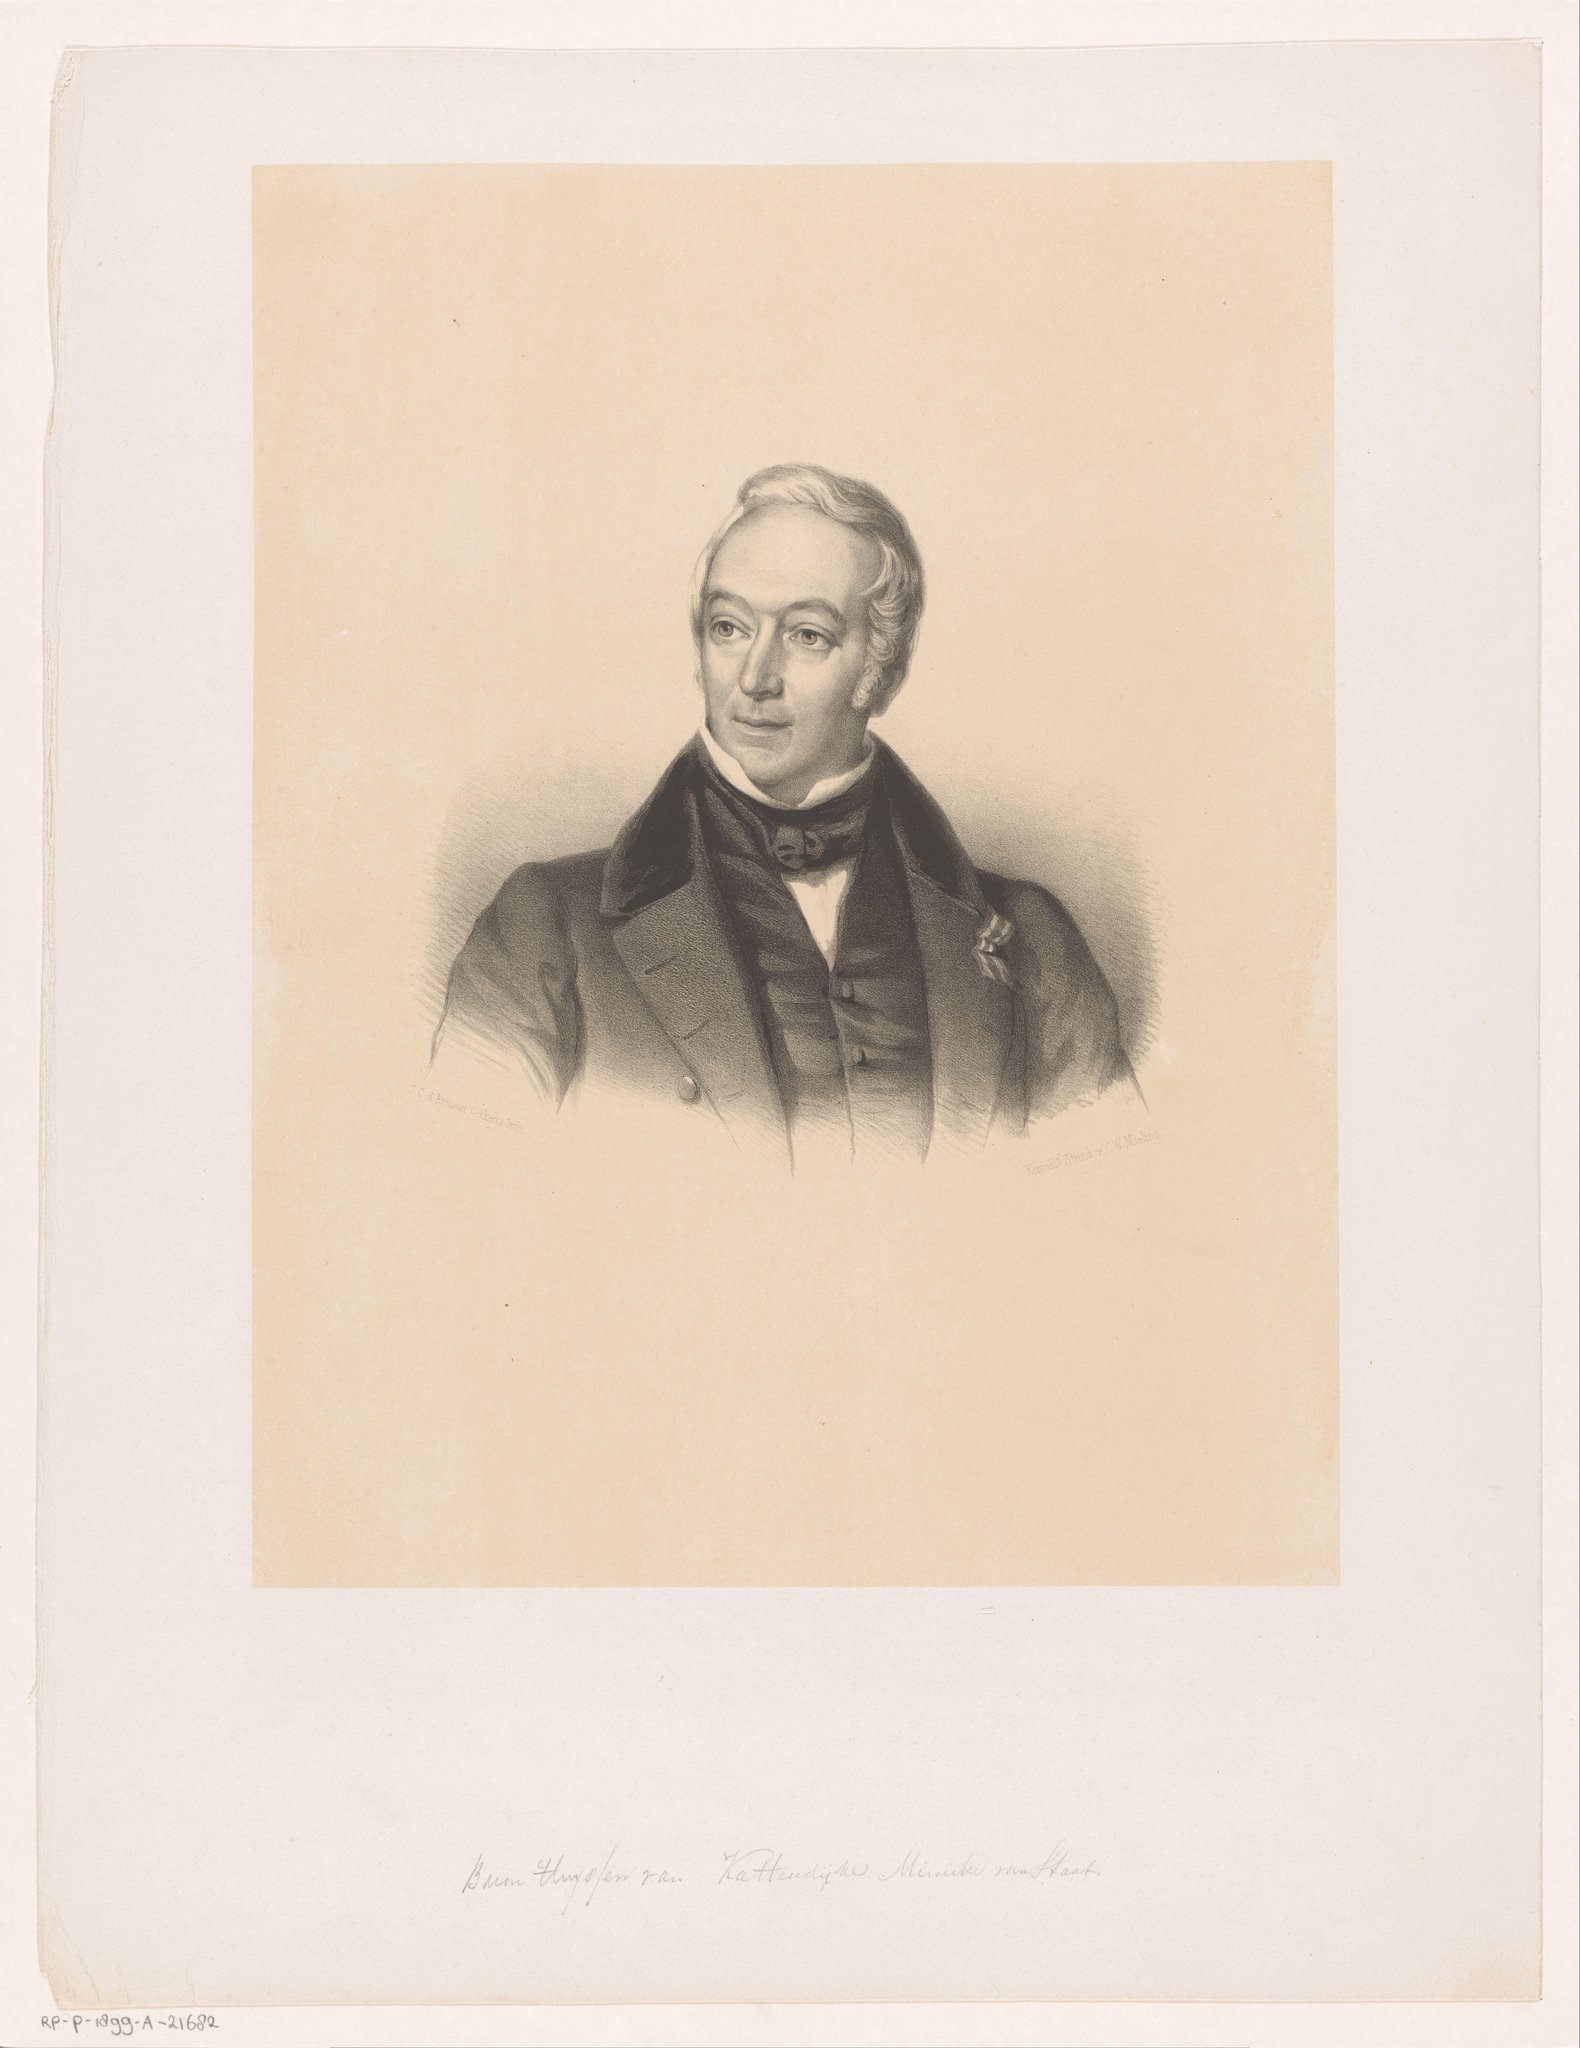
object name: print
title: Portret van Johan Willem Huyssen van Kattendijke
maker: johannes christiaan d arnaud gerkens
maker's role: draughtsman, print maker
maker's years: 1823-1892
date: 1833-1854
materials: paper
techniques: tone lithography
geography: the hague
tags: middelburg, paris, historical persons (+ head (and shoulders) (portrait)), knighthood order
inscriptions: collector's mark: Lugt 2228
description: De geportretteerde kijkt naar links. Hij draagt een ridderorde in zijn knoopsgat.